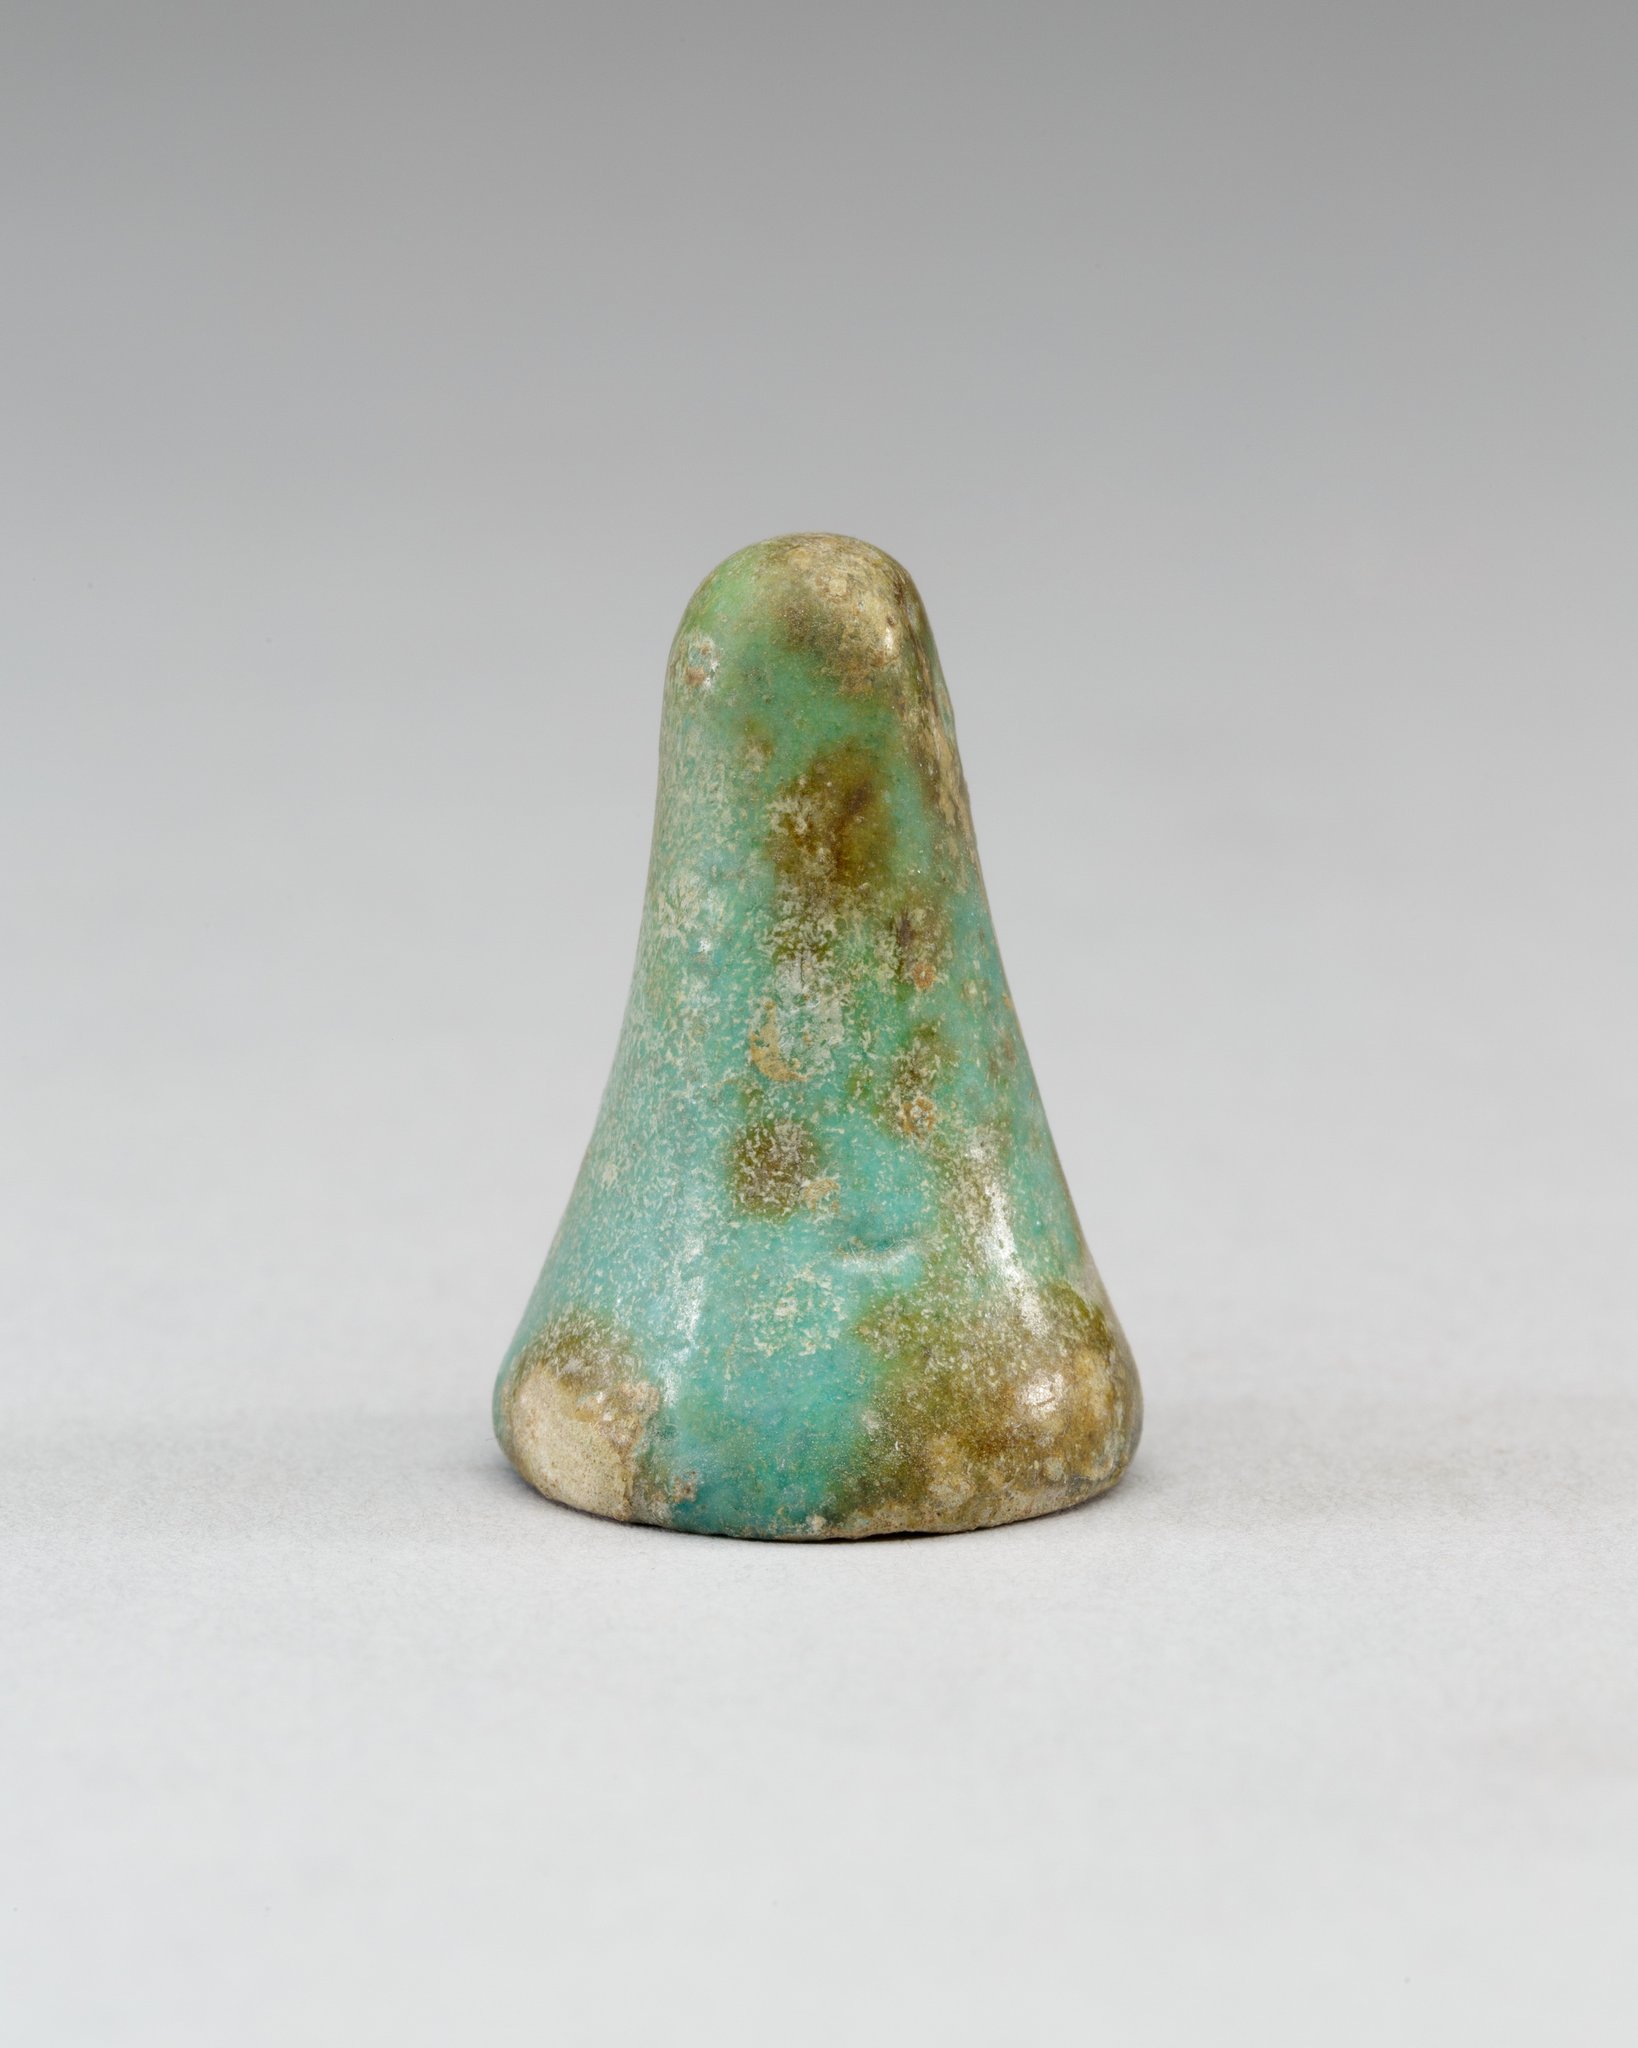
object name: game piece, conical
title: Conical Game Piece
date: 1504-1447 BCE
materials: faience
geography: egypt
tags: games